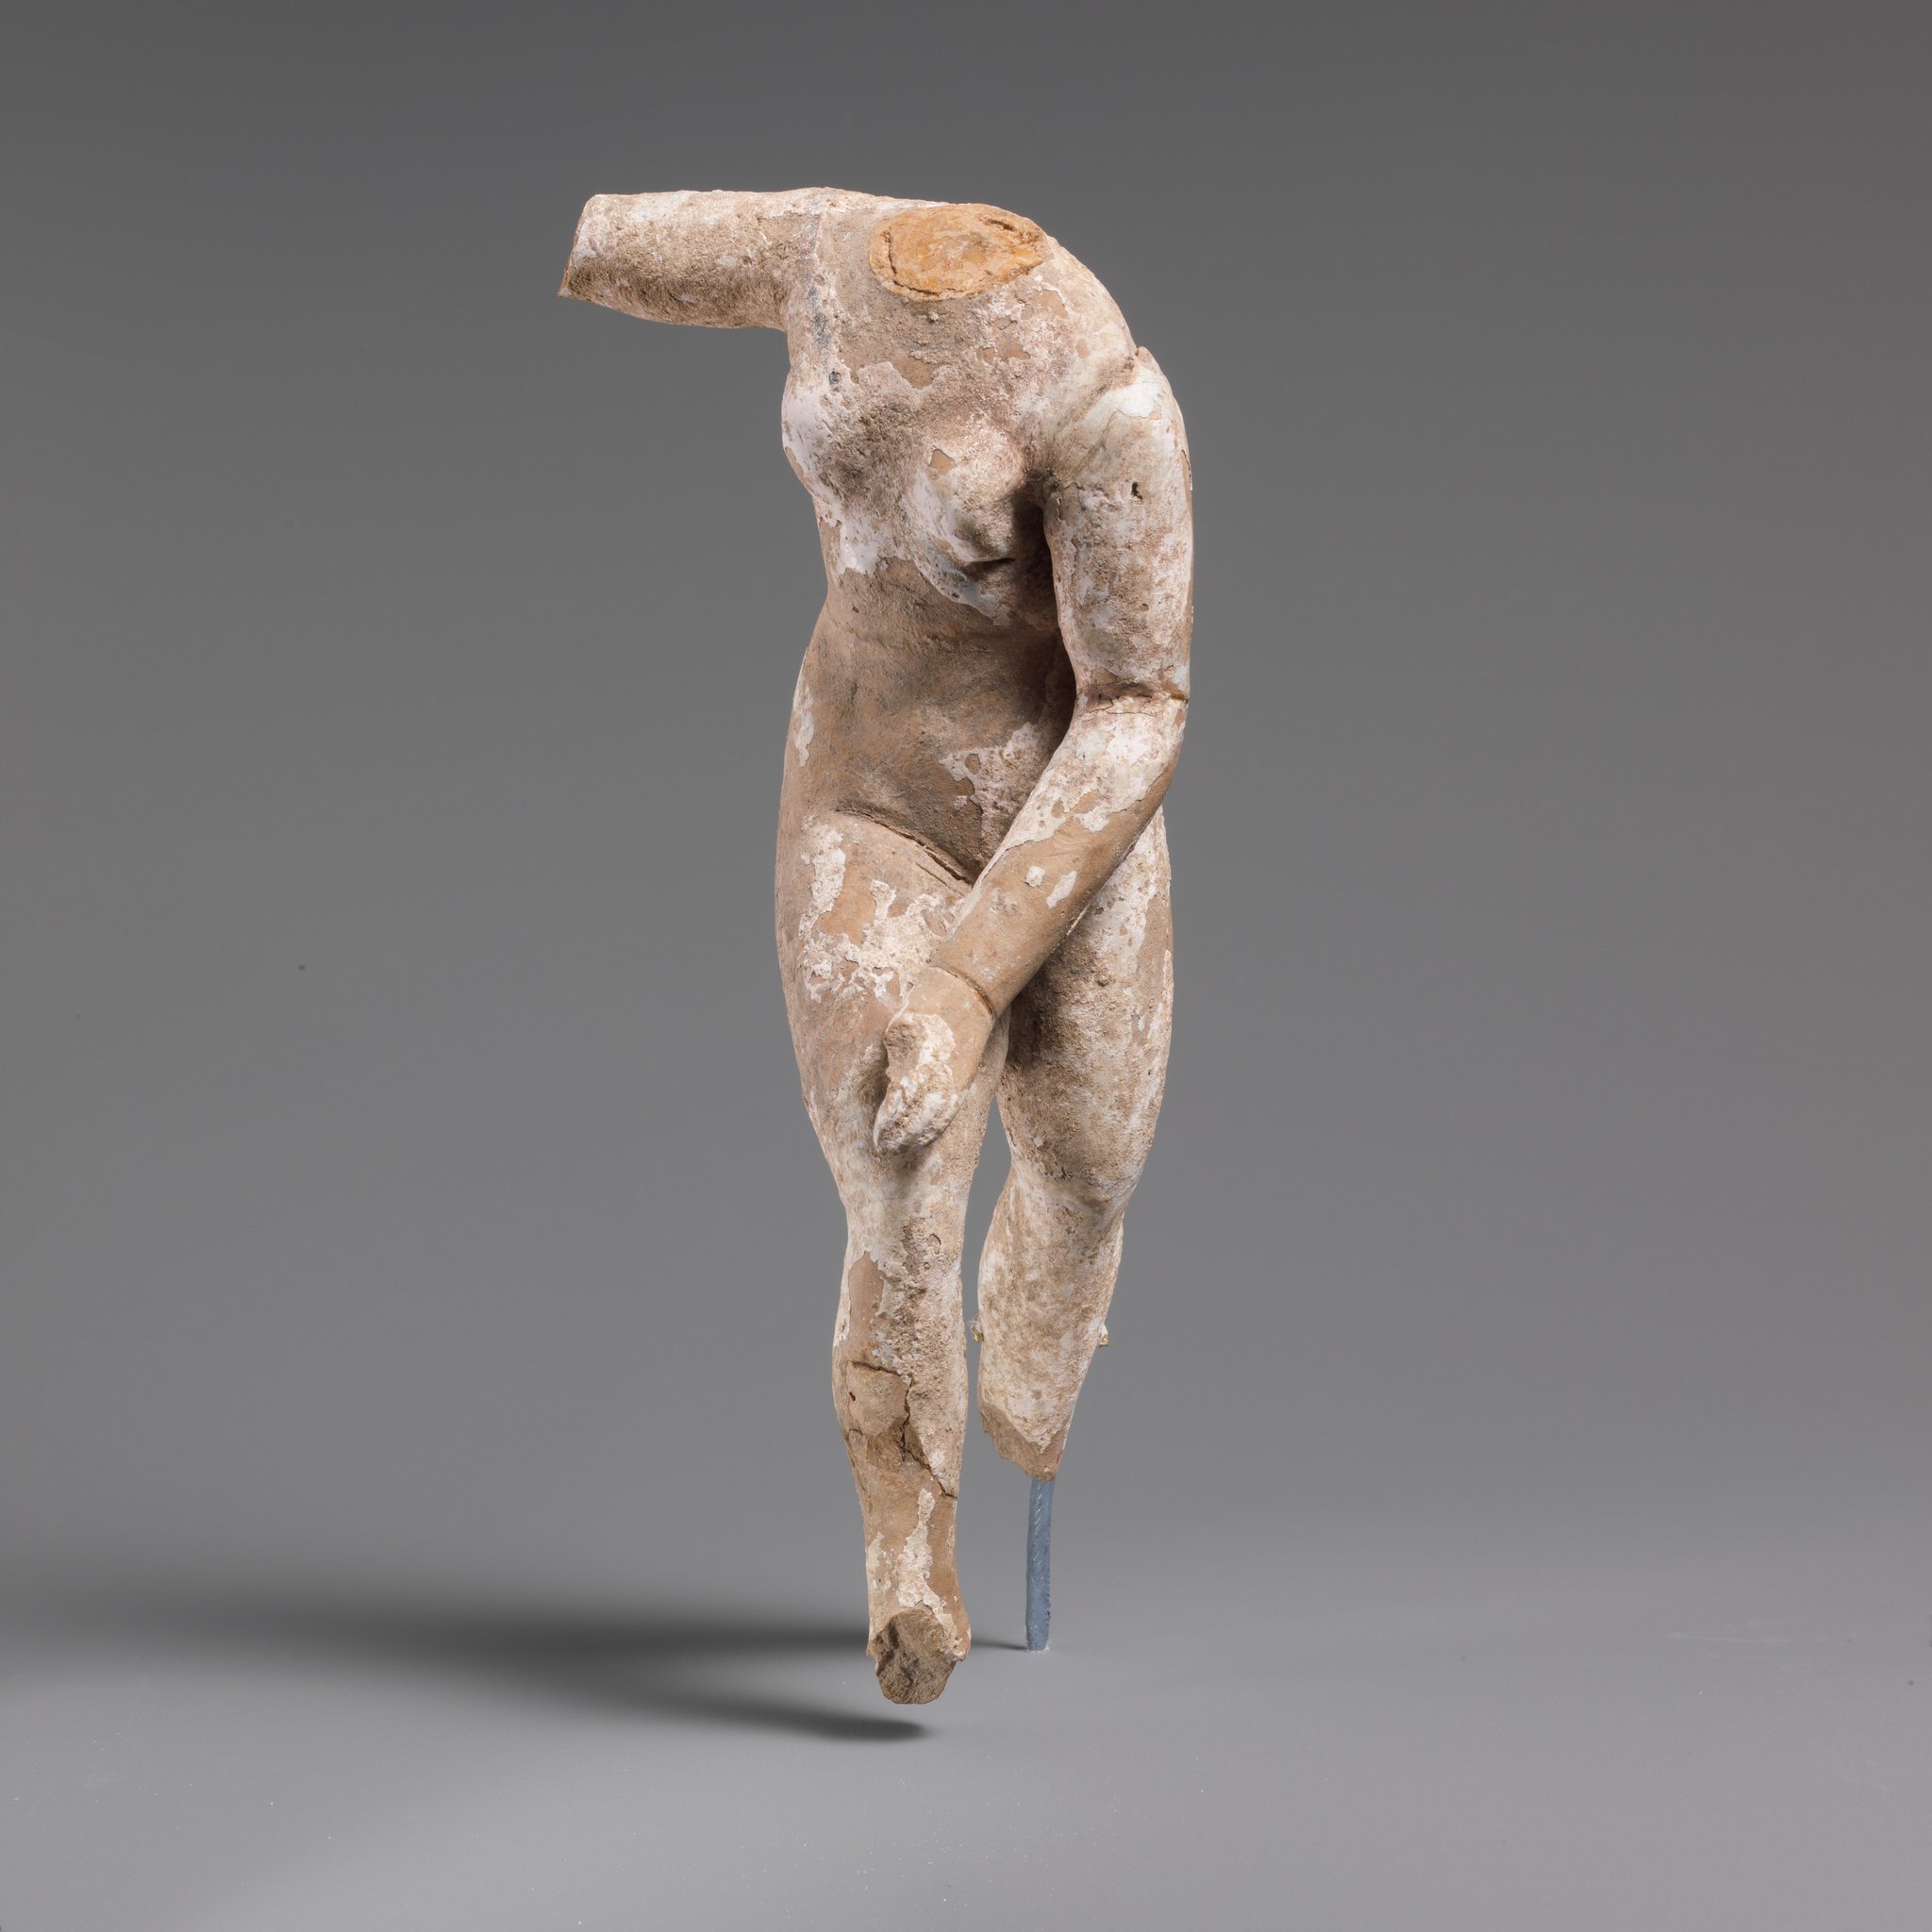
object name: statuette of a woman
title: Terracotta nude female statuette, perhaps Aphrodite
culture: greek, south italian, tarentine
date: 300-201 BCE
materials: terracotta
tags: aphrodite